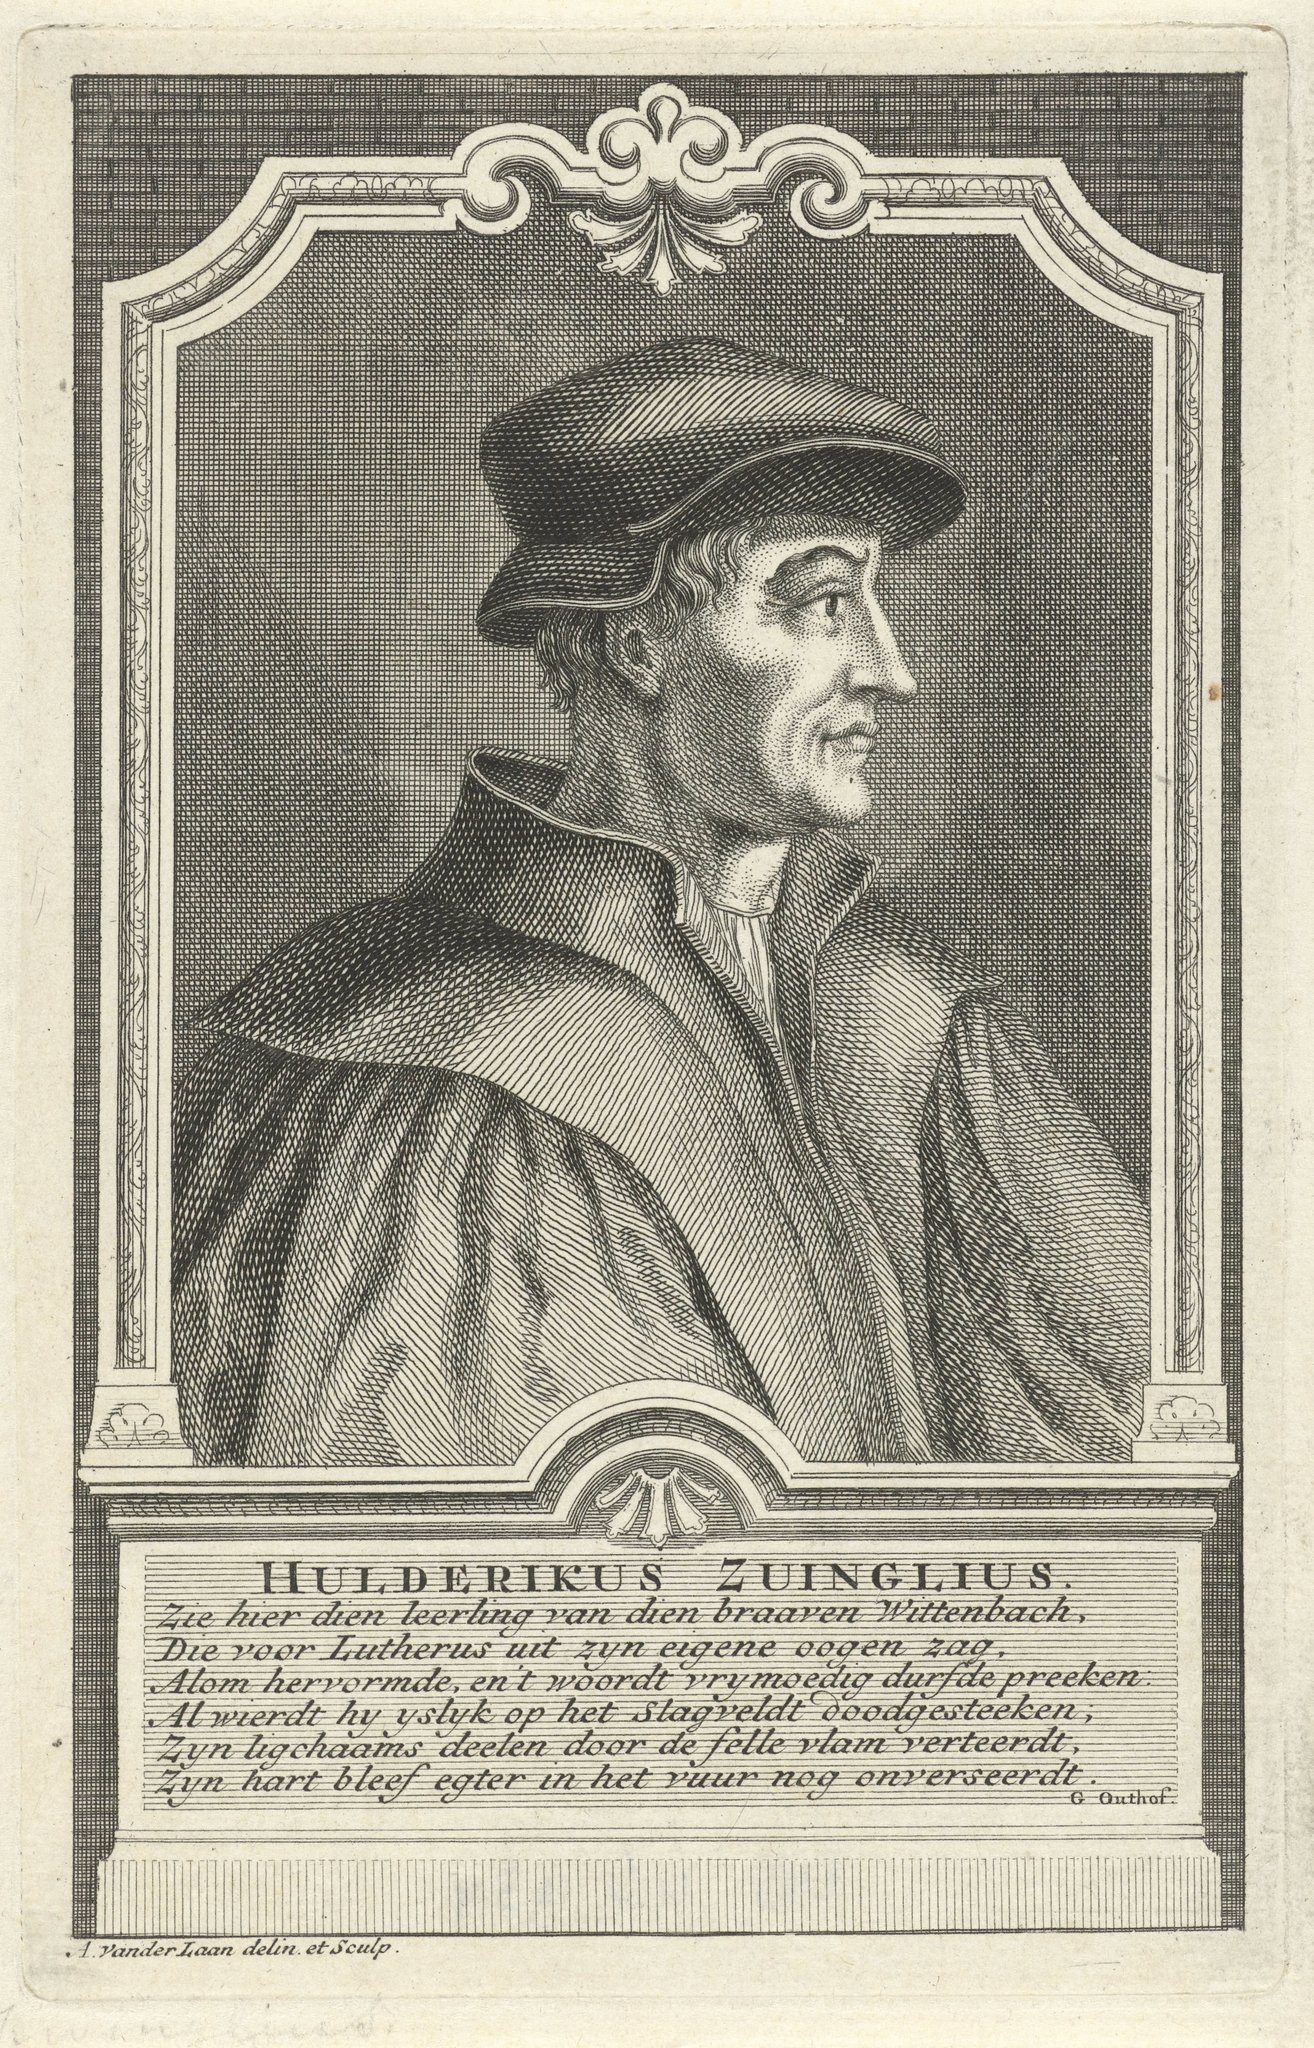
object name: print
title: Portret van Hulderikus Zuinglius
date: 1694-1755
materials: paper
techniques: engraving, etching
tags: hulderikus zuinglius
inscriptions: collector's mark: Lugt 2228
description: Portretbuste naar rechts van Hulderikus Zuinglius, met baret. Rondom een ornamentele omlijsting, onder het portret de naam van de geportretteerde gevolgd door een zesregelig Nederlands vers.